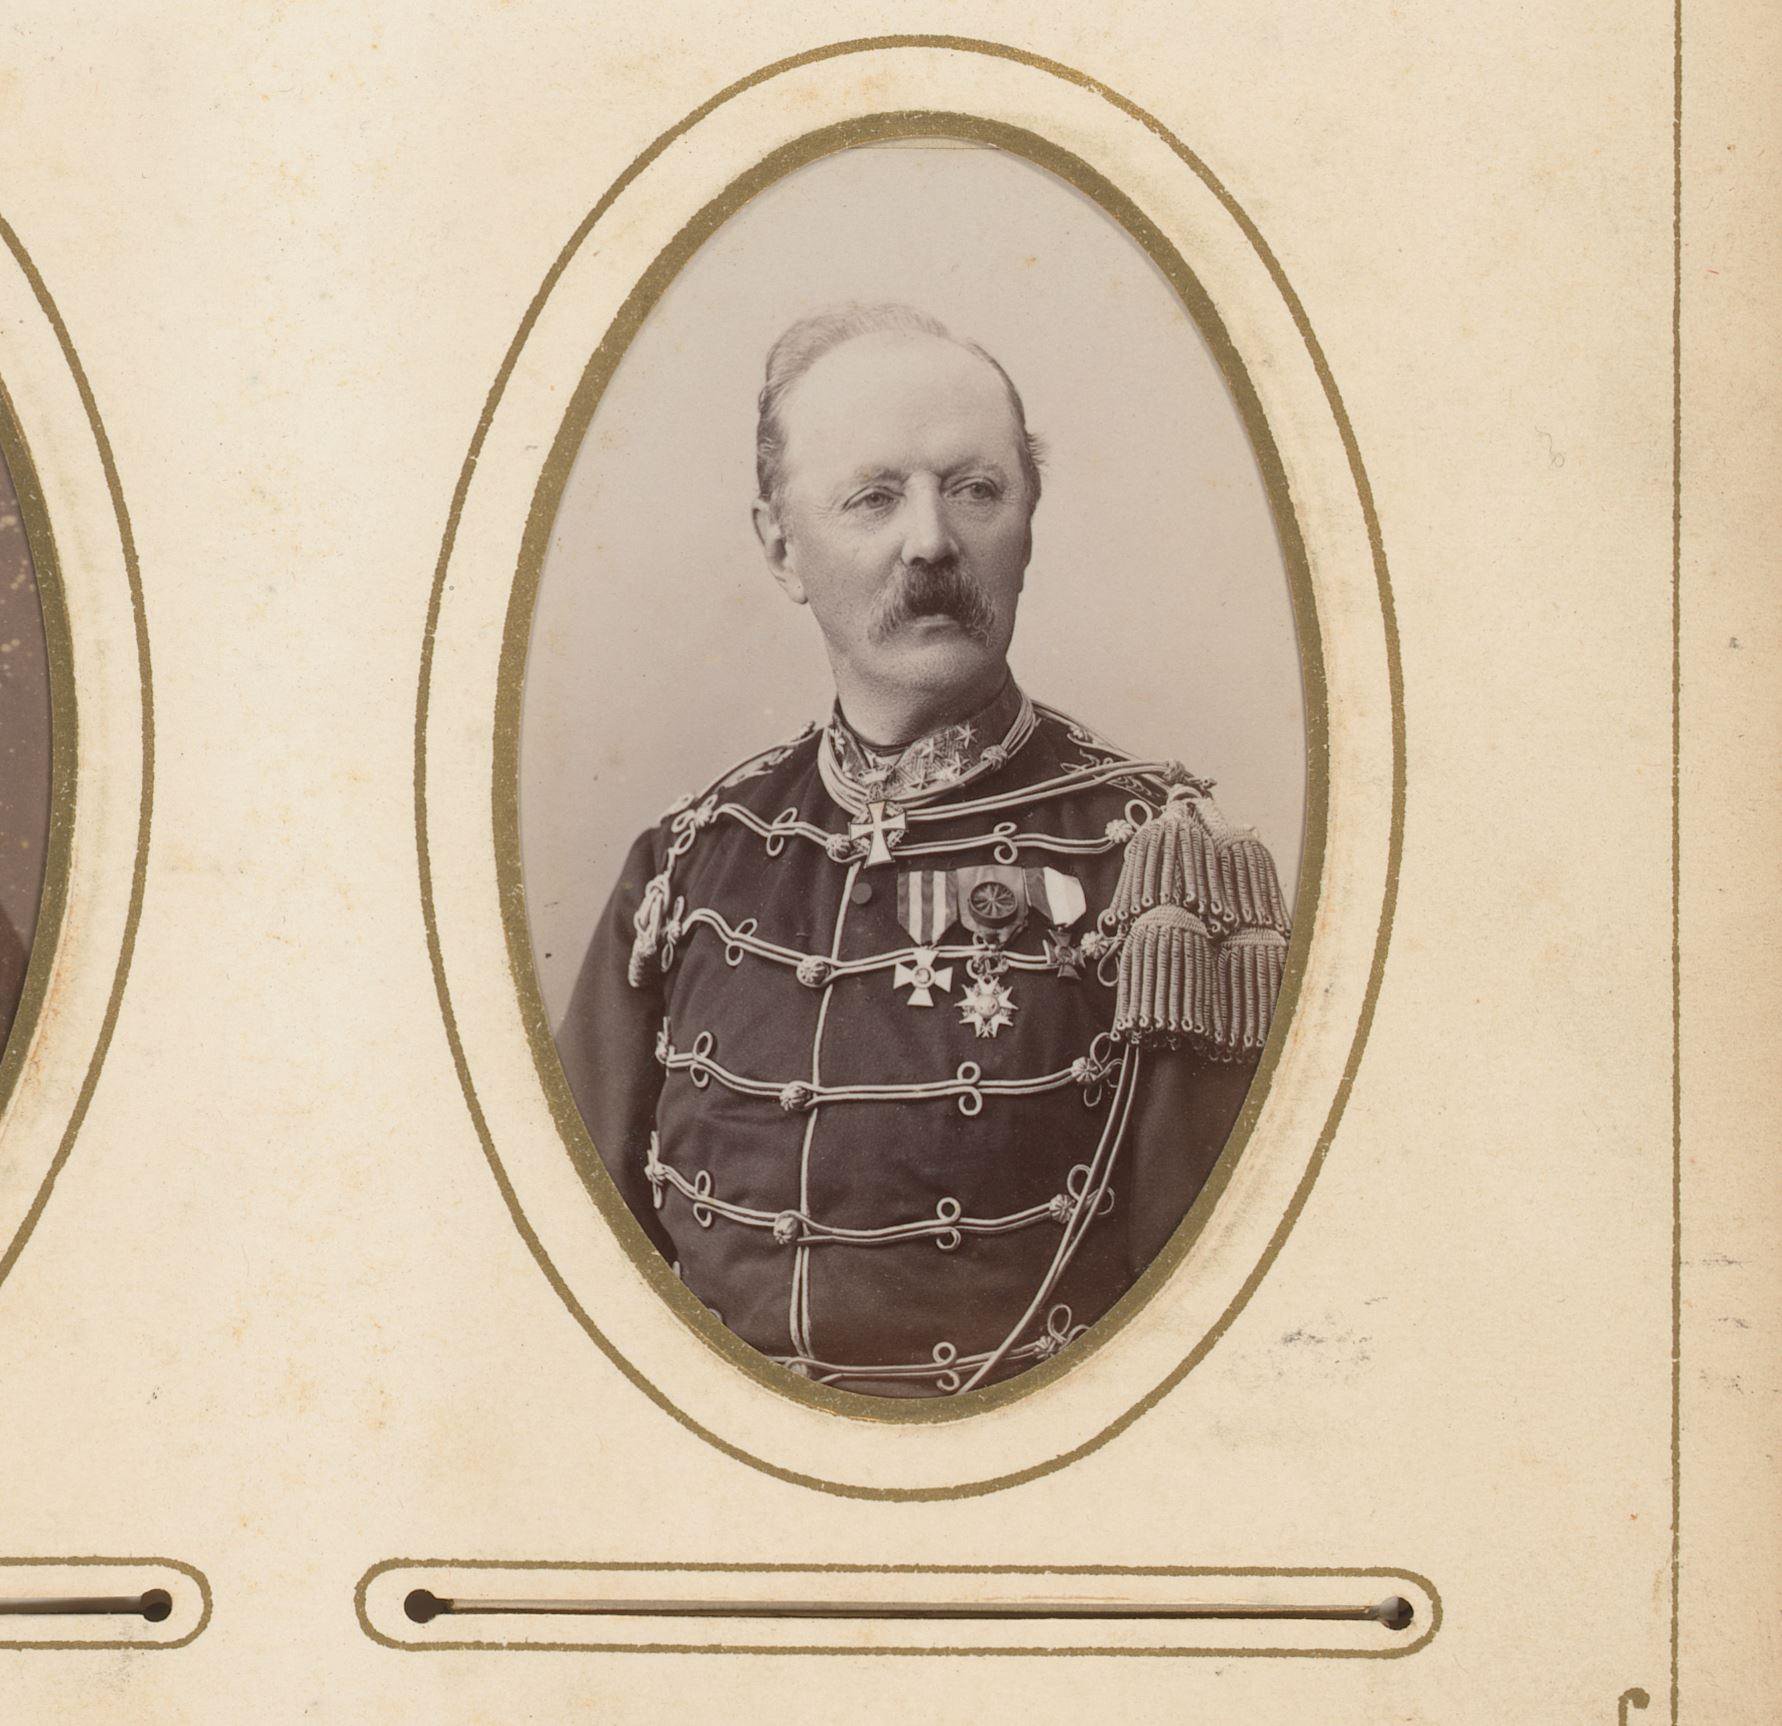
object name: album leaf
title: Portret van een man in militair uniform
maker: franz reissig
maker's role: fotograaf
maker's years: 1852-1936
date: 1882-1900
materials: cardboard, photographic support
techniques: albumen print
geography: leeuwarden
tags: historical persons, (military) uniforms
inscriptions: inscription: ‘F. Reissig - Breda.’